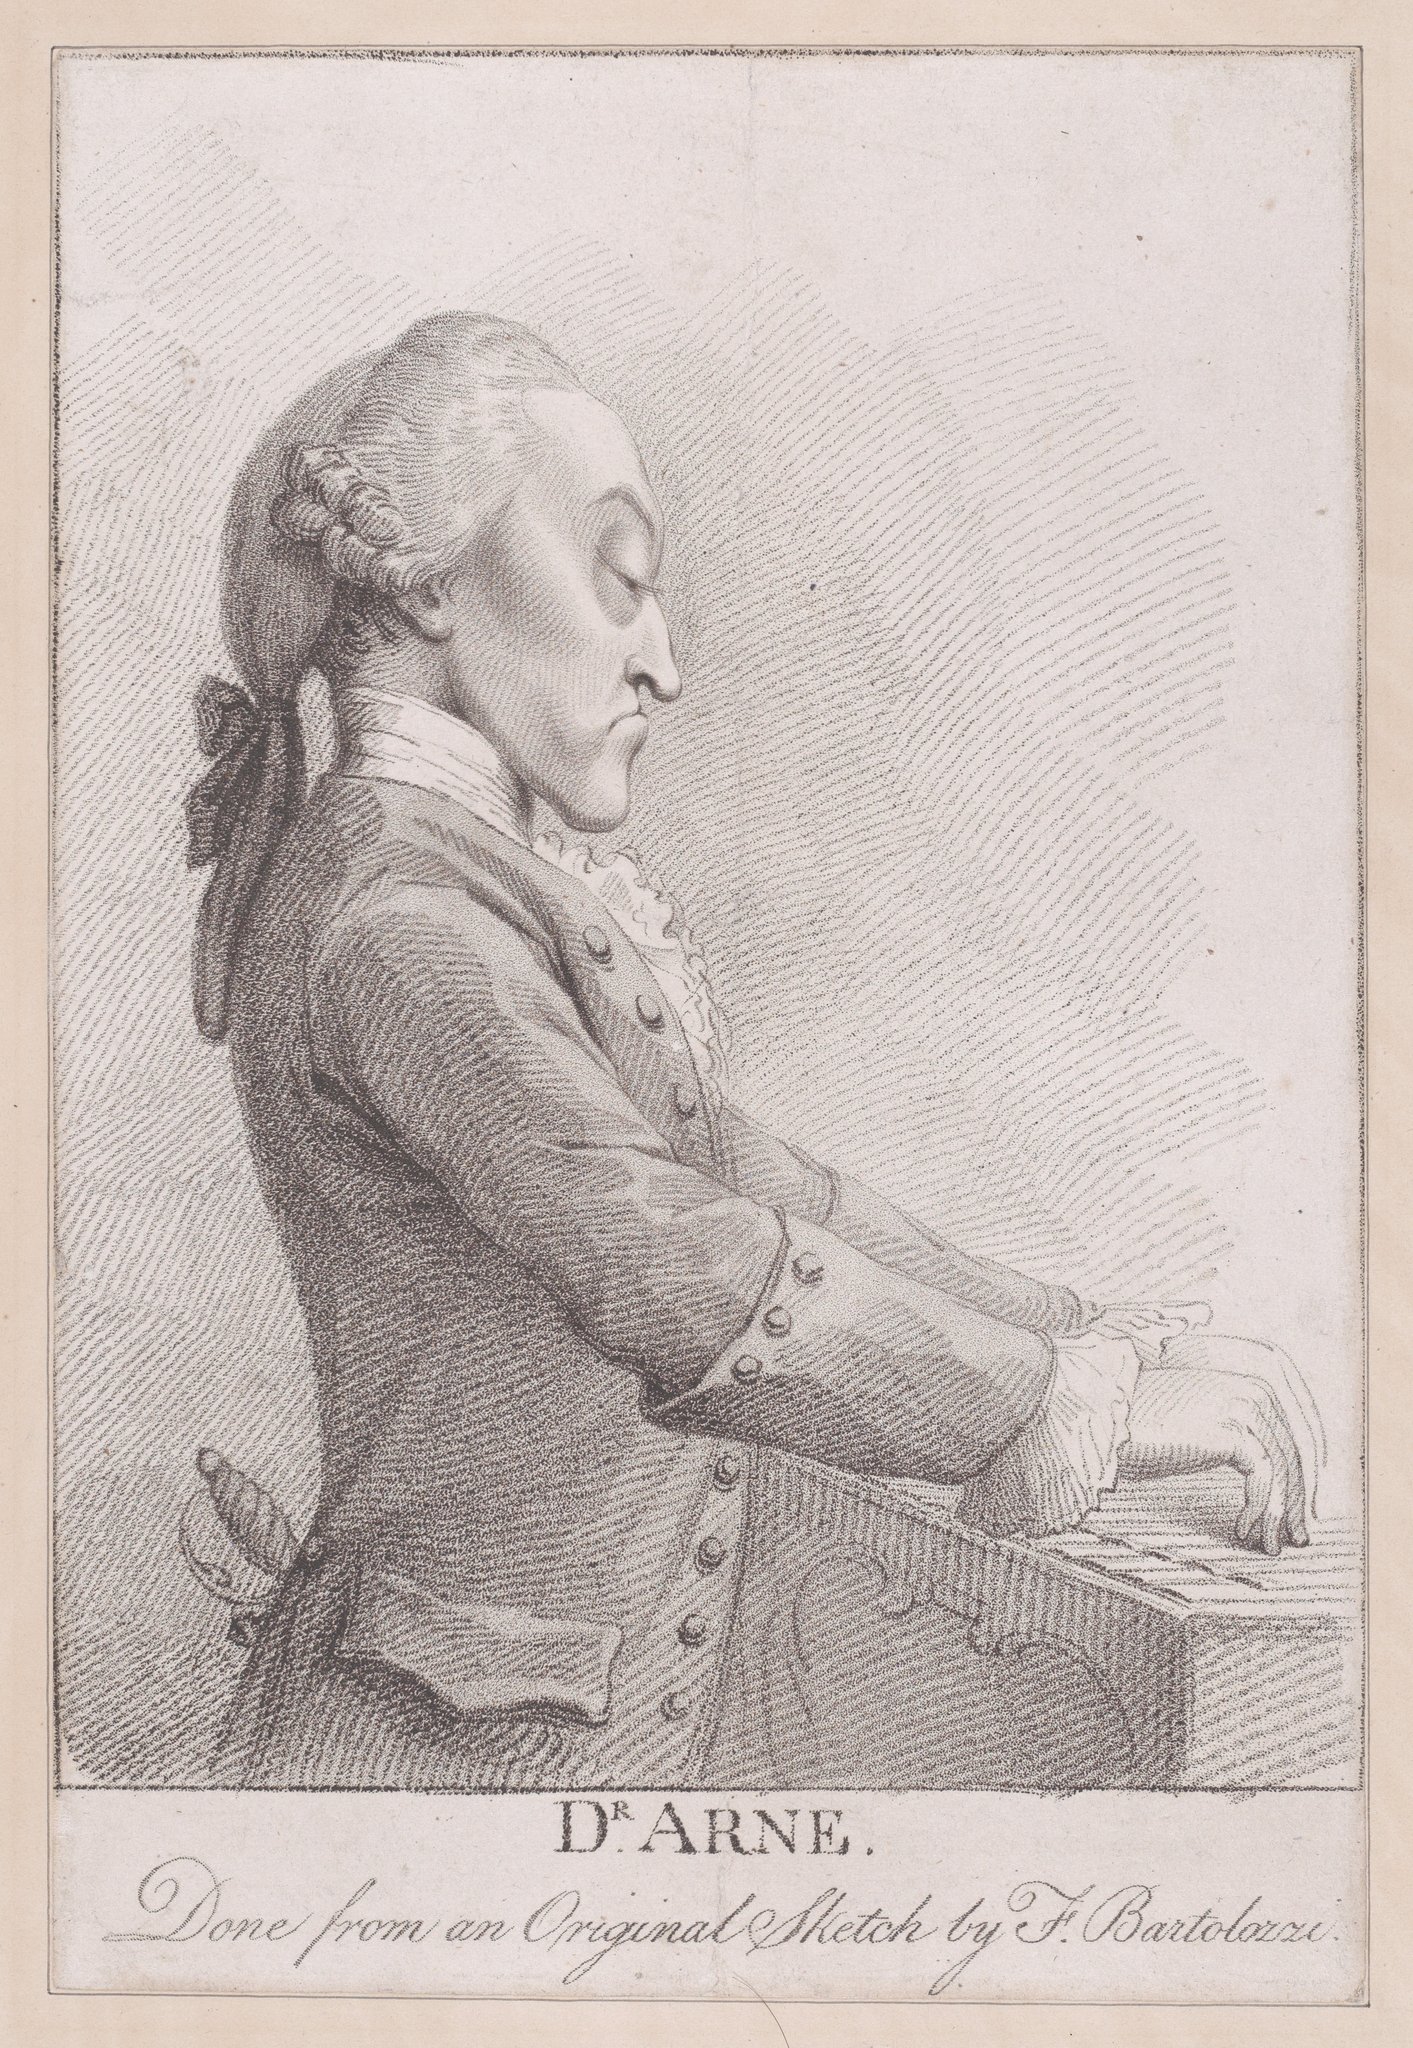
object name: print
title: Dr. Arne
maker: francesco bartolozzi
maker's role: artist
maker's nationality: italian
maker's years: 1728-1815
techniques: printmaking, etching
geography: london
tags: men,caricature